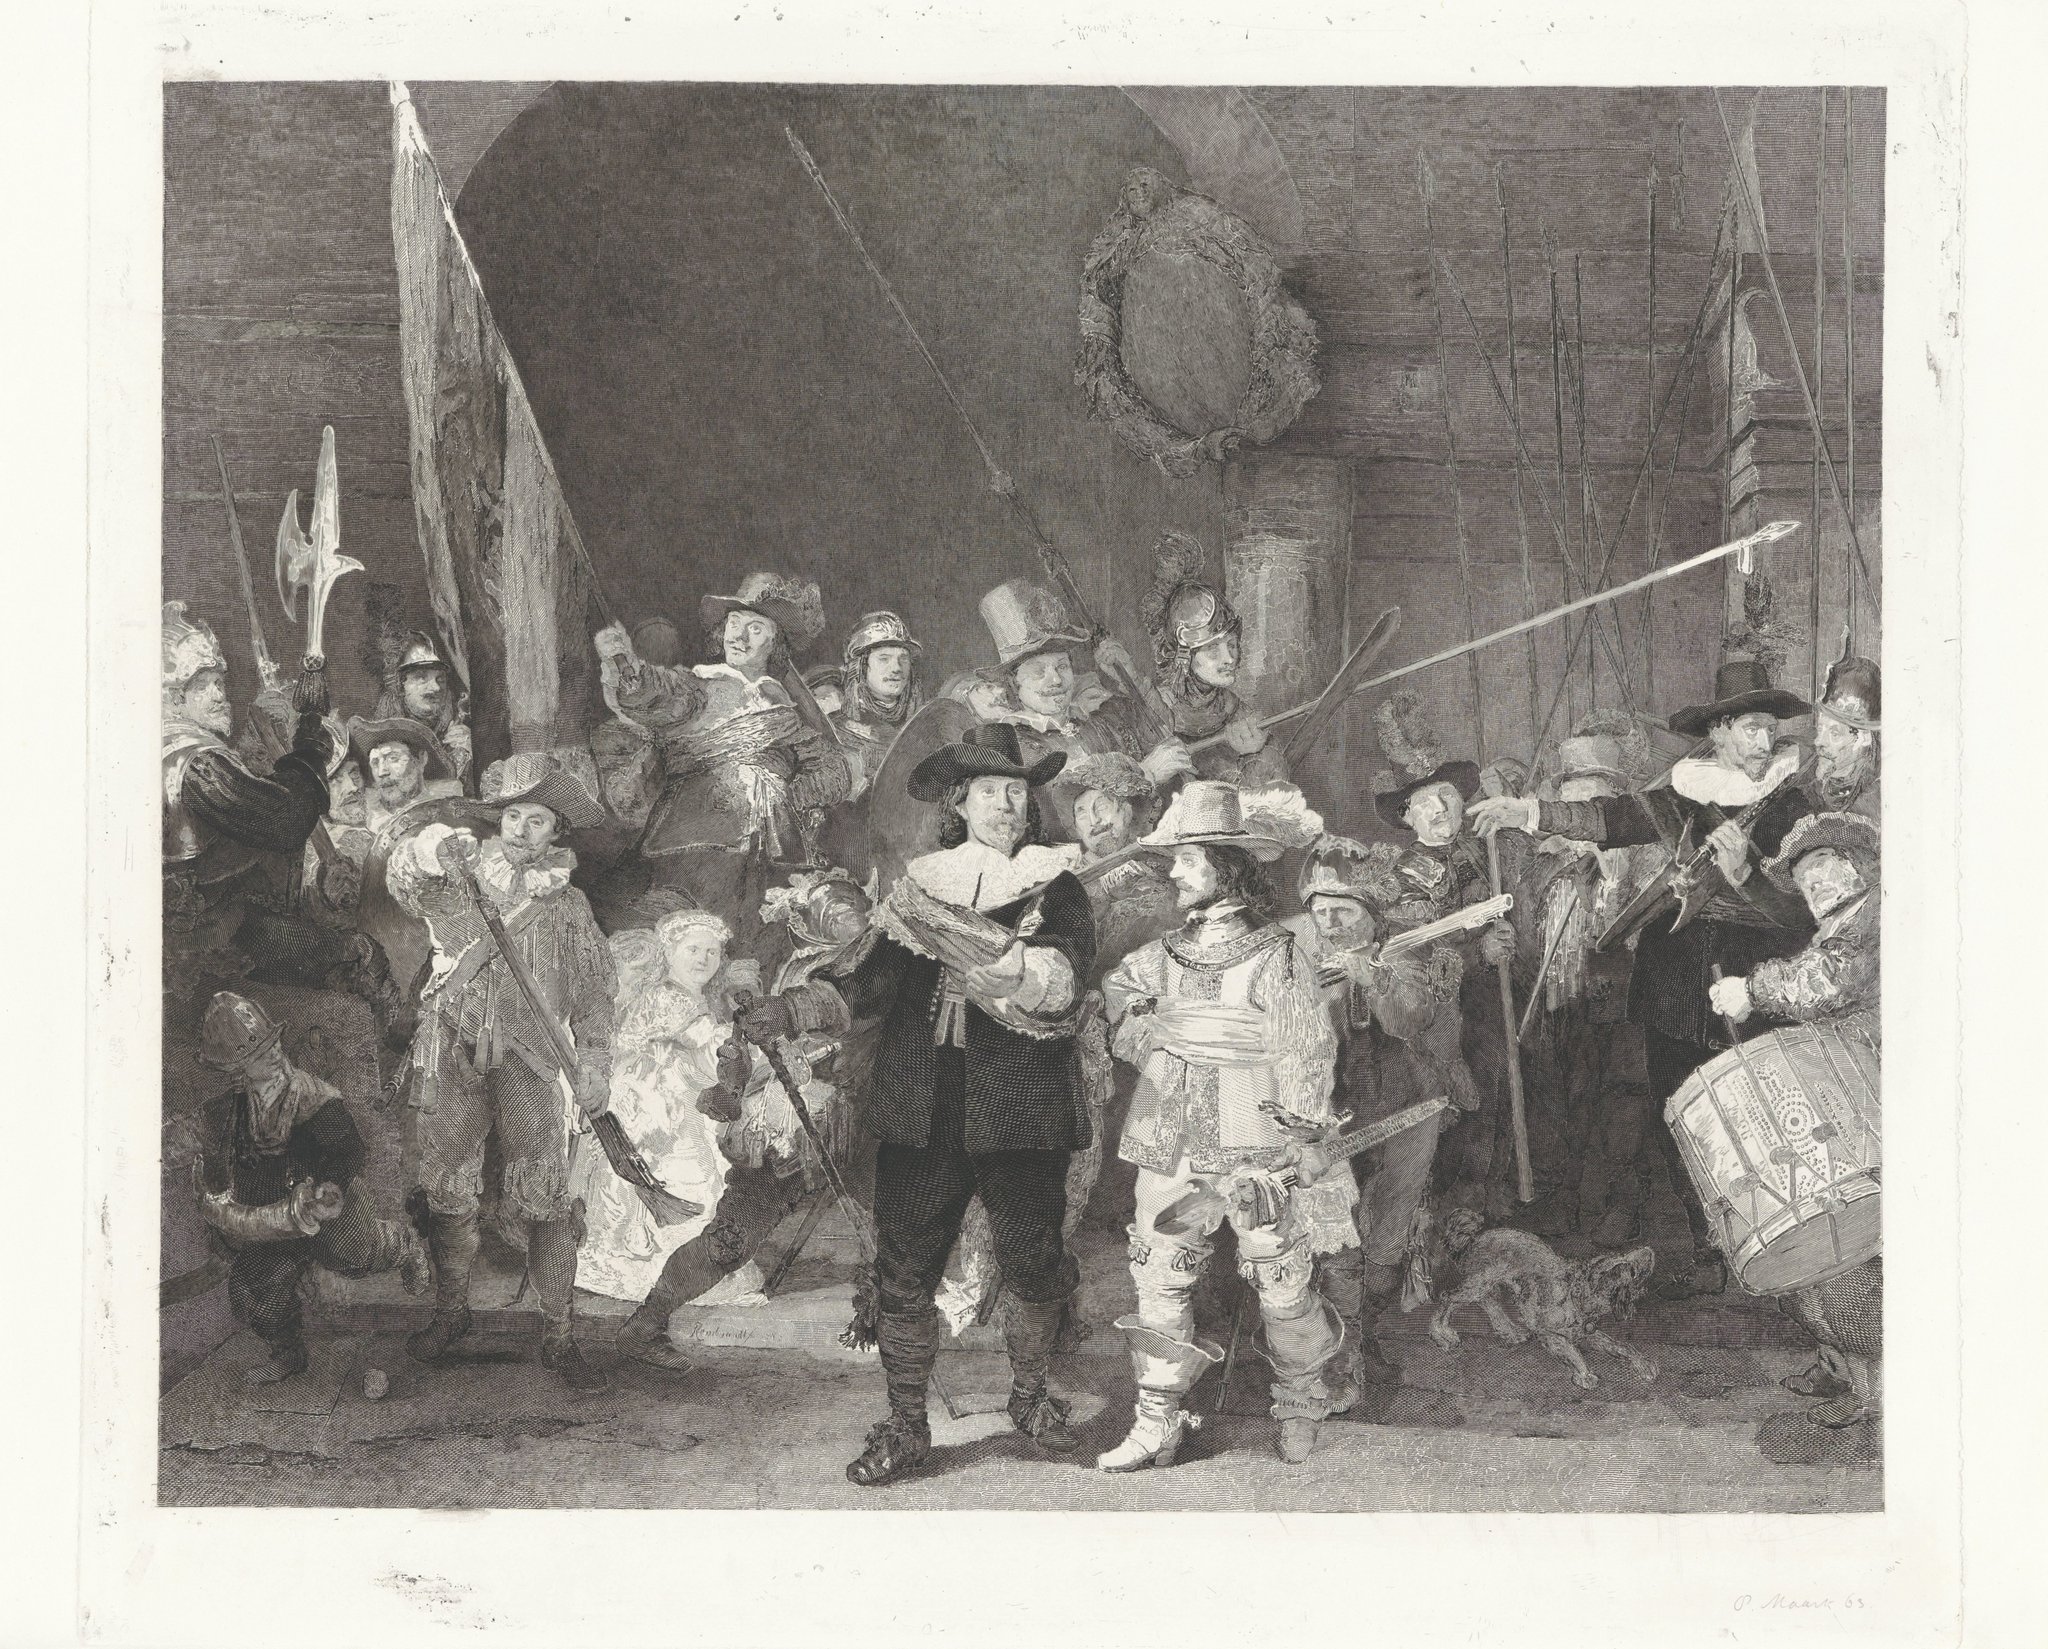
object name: print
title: Het korporaalschap van kapitein Frans Banninck Cocq en luitenant Willem van Ruytenburch, bekend als de 'Nachtwacht'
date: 1863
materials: paper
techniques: drypoint, engraving, etching, roulette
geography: amsterdam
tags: proclamation of peace, celebration meal, feast, banquet, festivities on events of national importance, picture, painting, land forces (+ citizen soldiery, civil guard, citizen militia), historical events and situations, dog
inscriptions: collector's mark: Lugt 2228, inscription: ‘8 Maart 63’